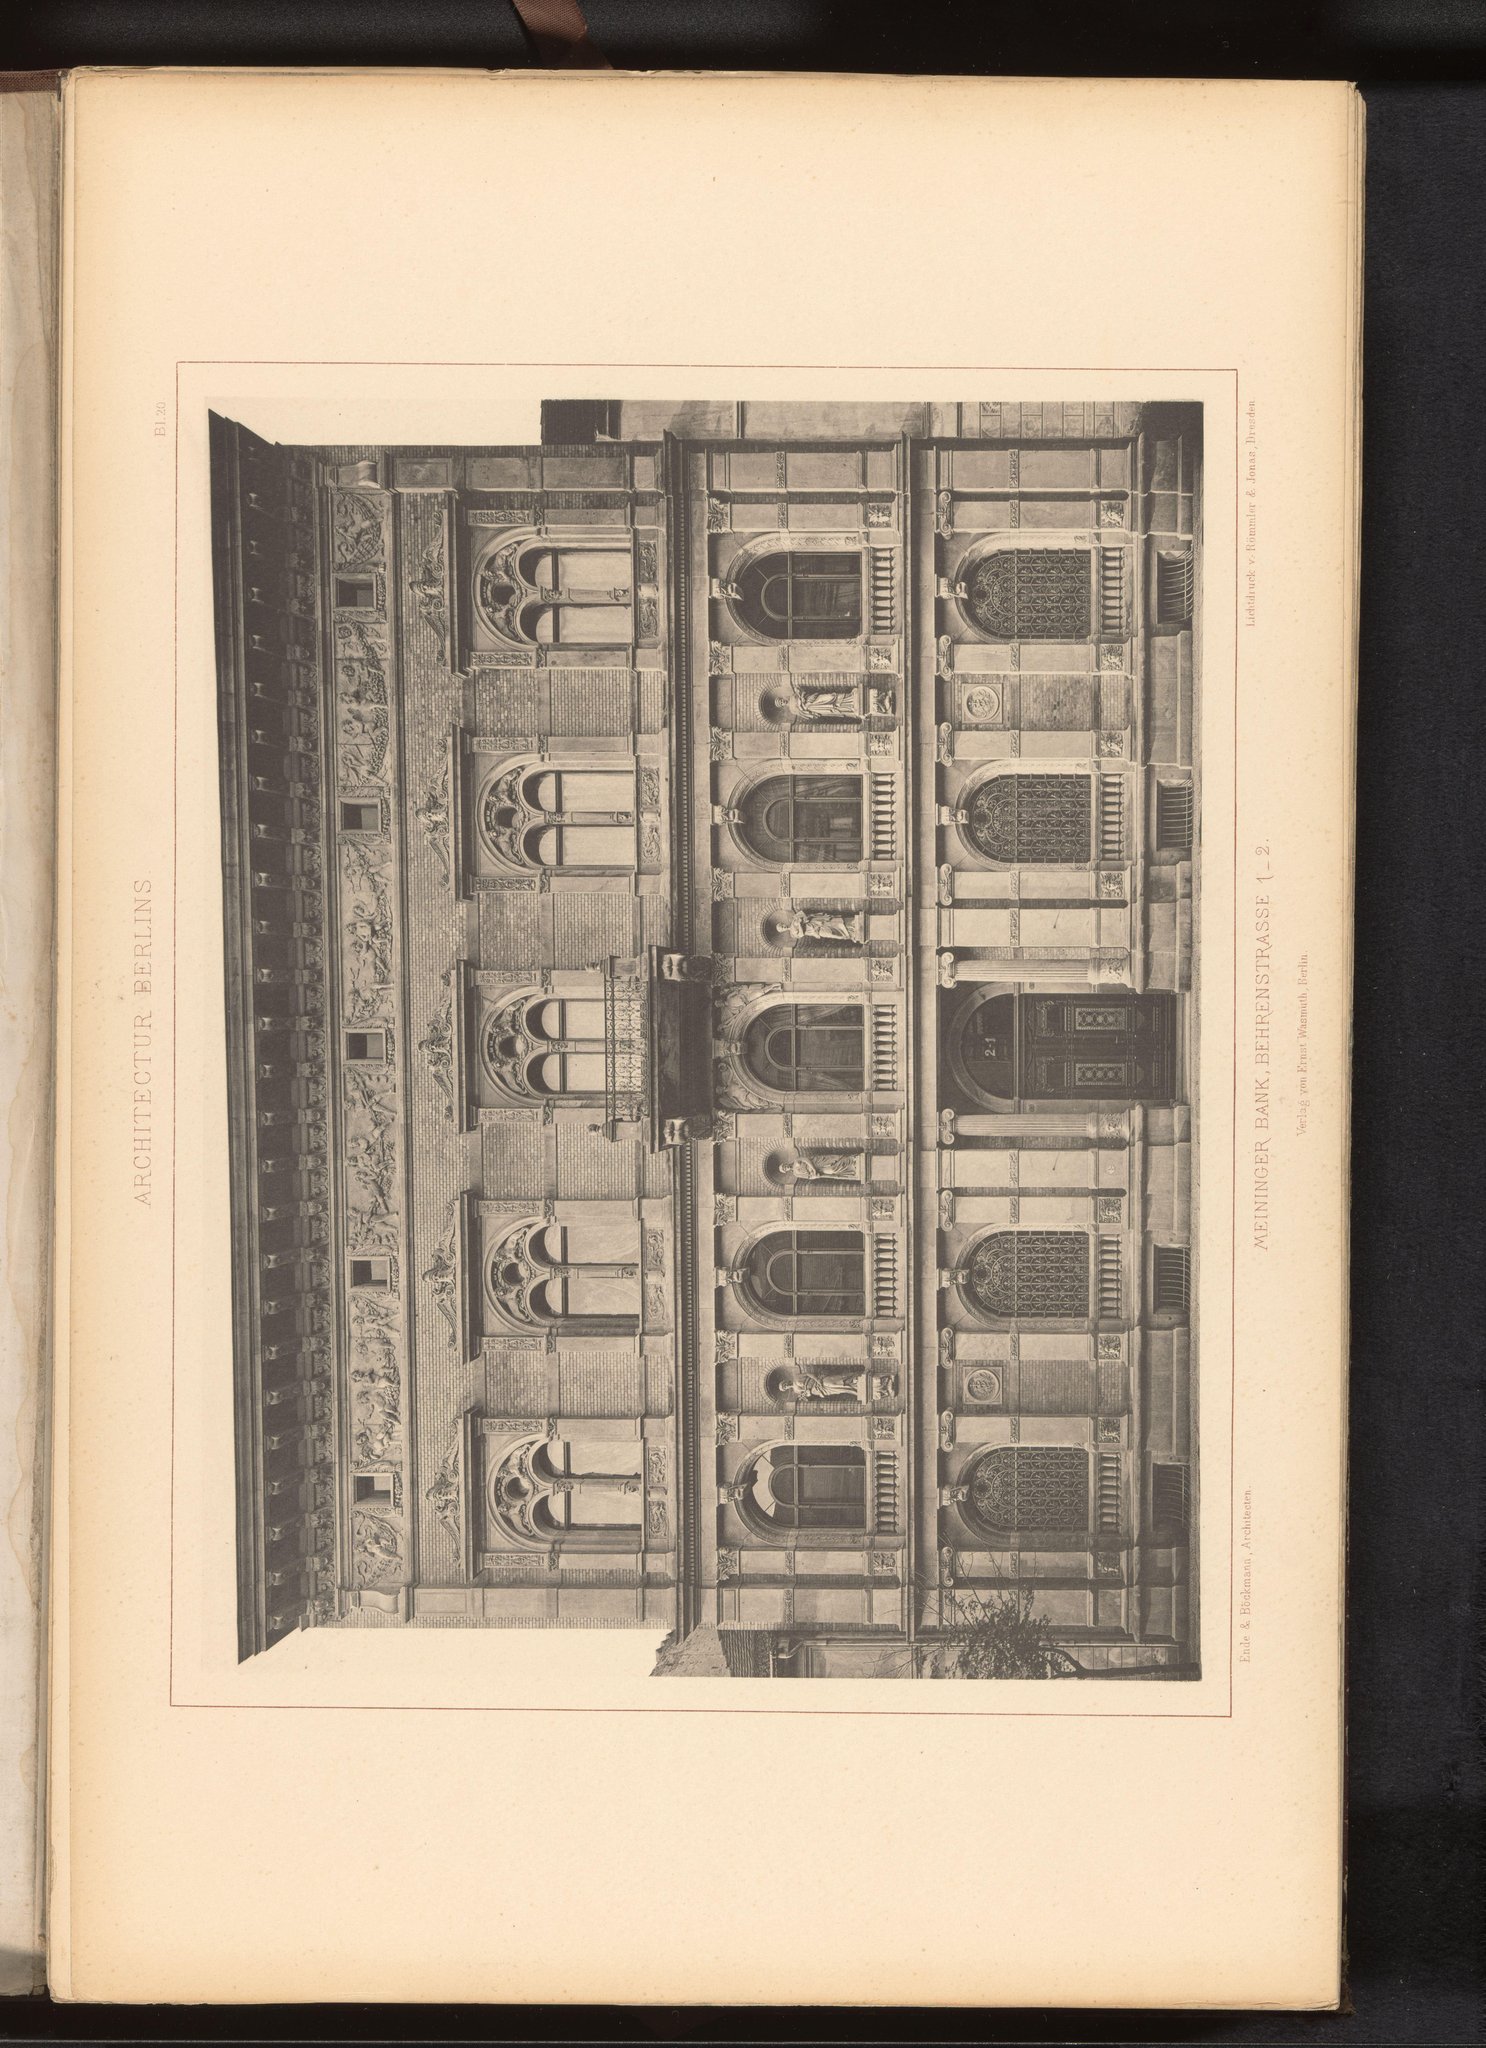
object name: photomechanical print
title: Meininger Bank, Behrenstrasse 1-2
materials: paper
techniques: photograph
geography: berlin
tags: bank, berlin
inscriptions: number: ‘Bl. 20.’, inscription: ‘Ende & Böckmann, Architecten.’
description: Deze prent maakt deel uit van een omslag met honderd prenten en zes tekstbladen.